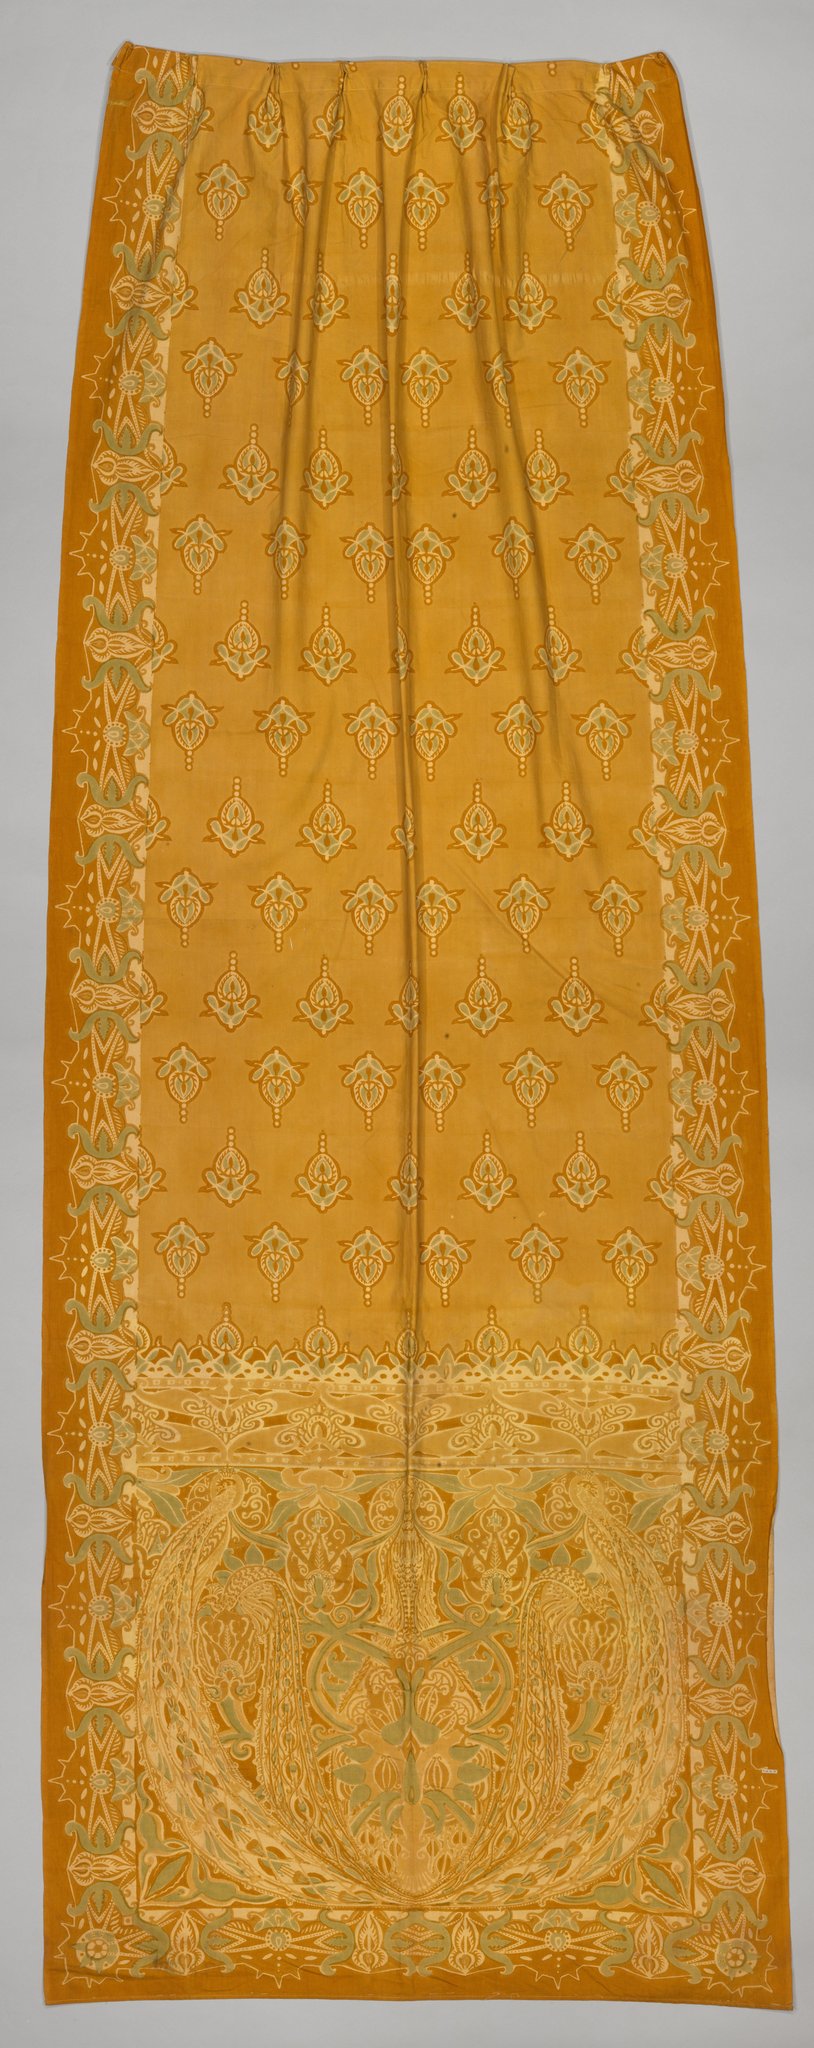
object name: curtain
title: Gordijn van bedrukte cretonne met geometrische decor en pauwen in naturel, okergeel en groen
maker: michiel duco crop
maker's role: designer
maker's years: 1862-1901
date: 1899-1900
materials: cotton, metal, paint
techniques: printing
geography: netherlands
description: Gordijn, bestaande uit één baan bedrukte cretonne met geometrische decor en drie pauwen aan de onderzijde in naturel, okergeel en lichtgroen. Voorzien van metalen haken.